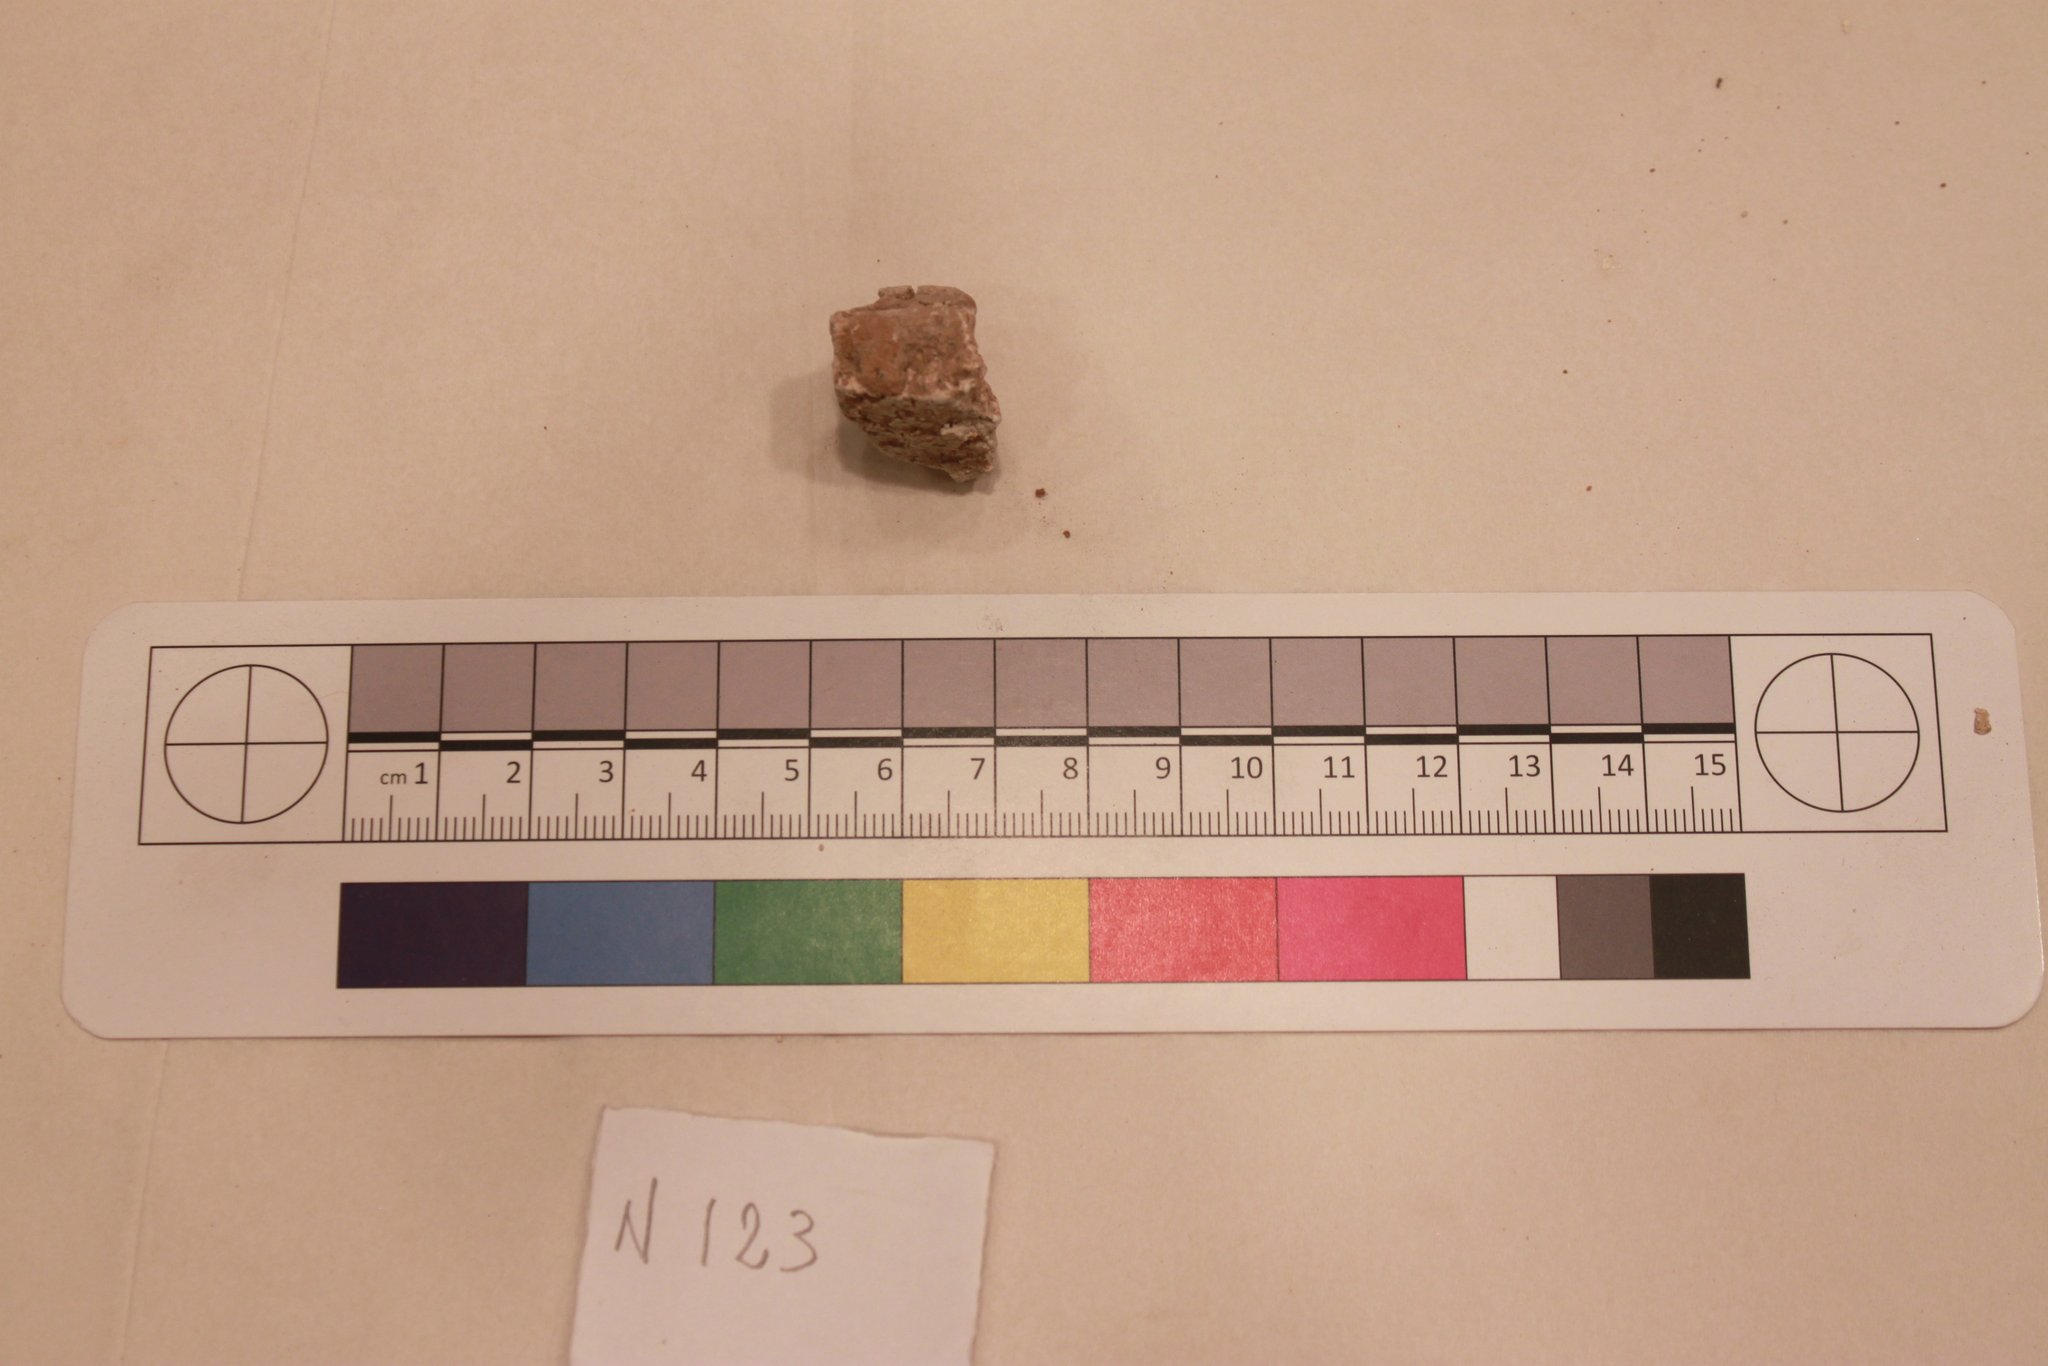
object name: fragment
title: Stucco Fragment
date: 701-1200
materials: plaster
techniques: carving, painting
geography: iran